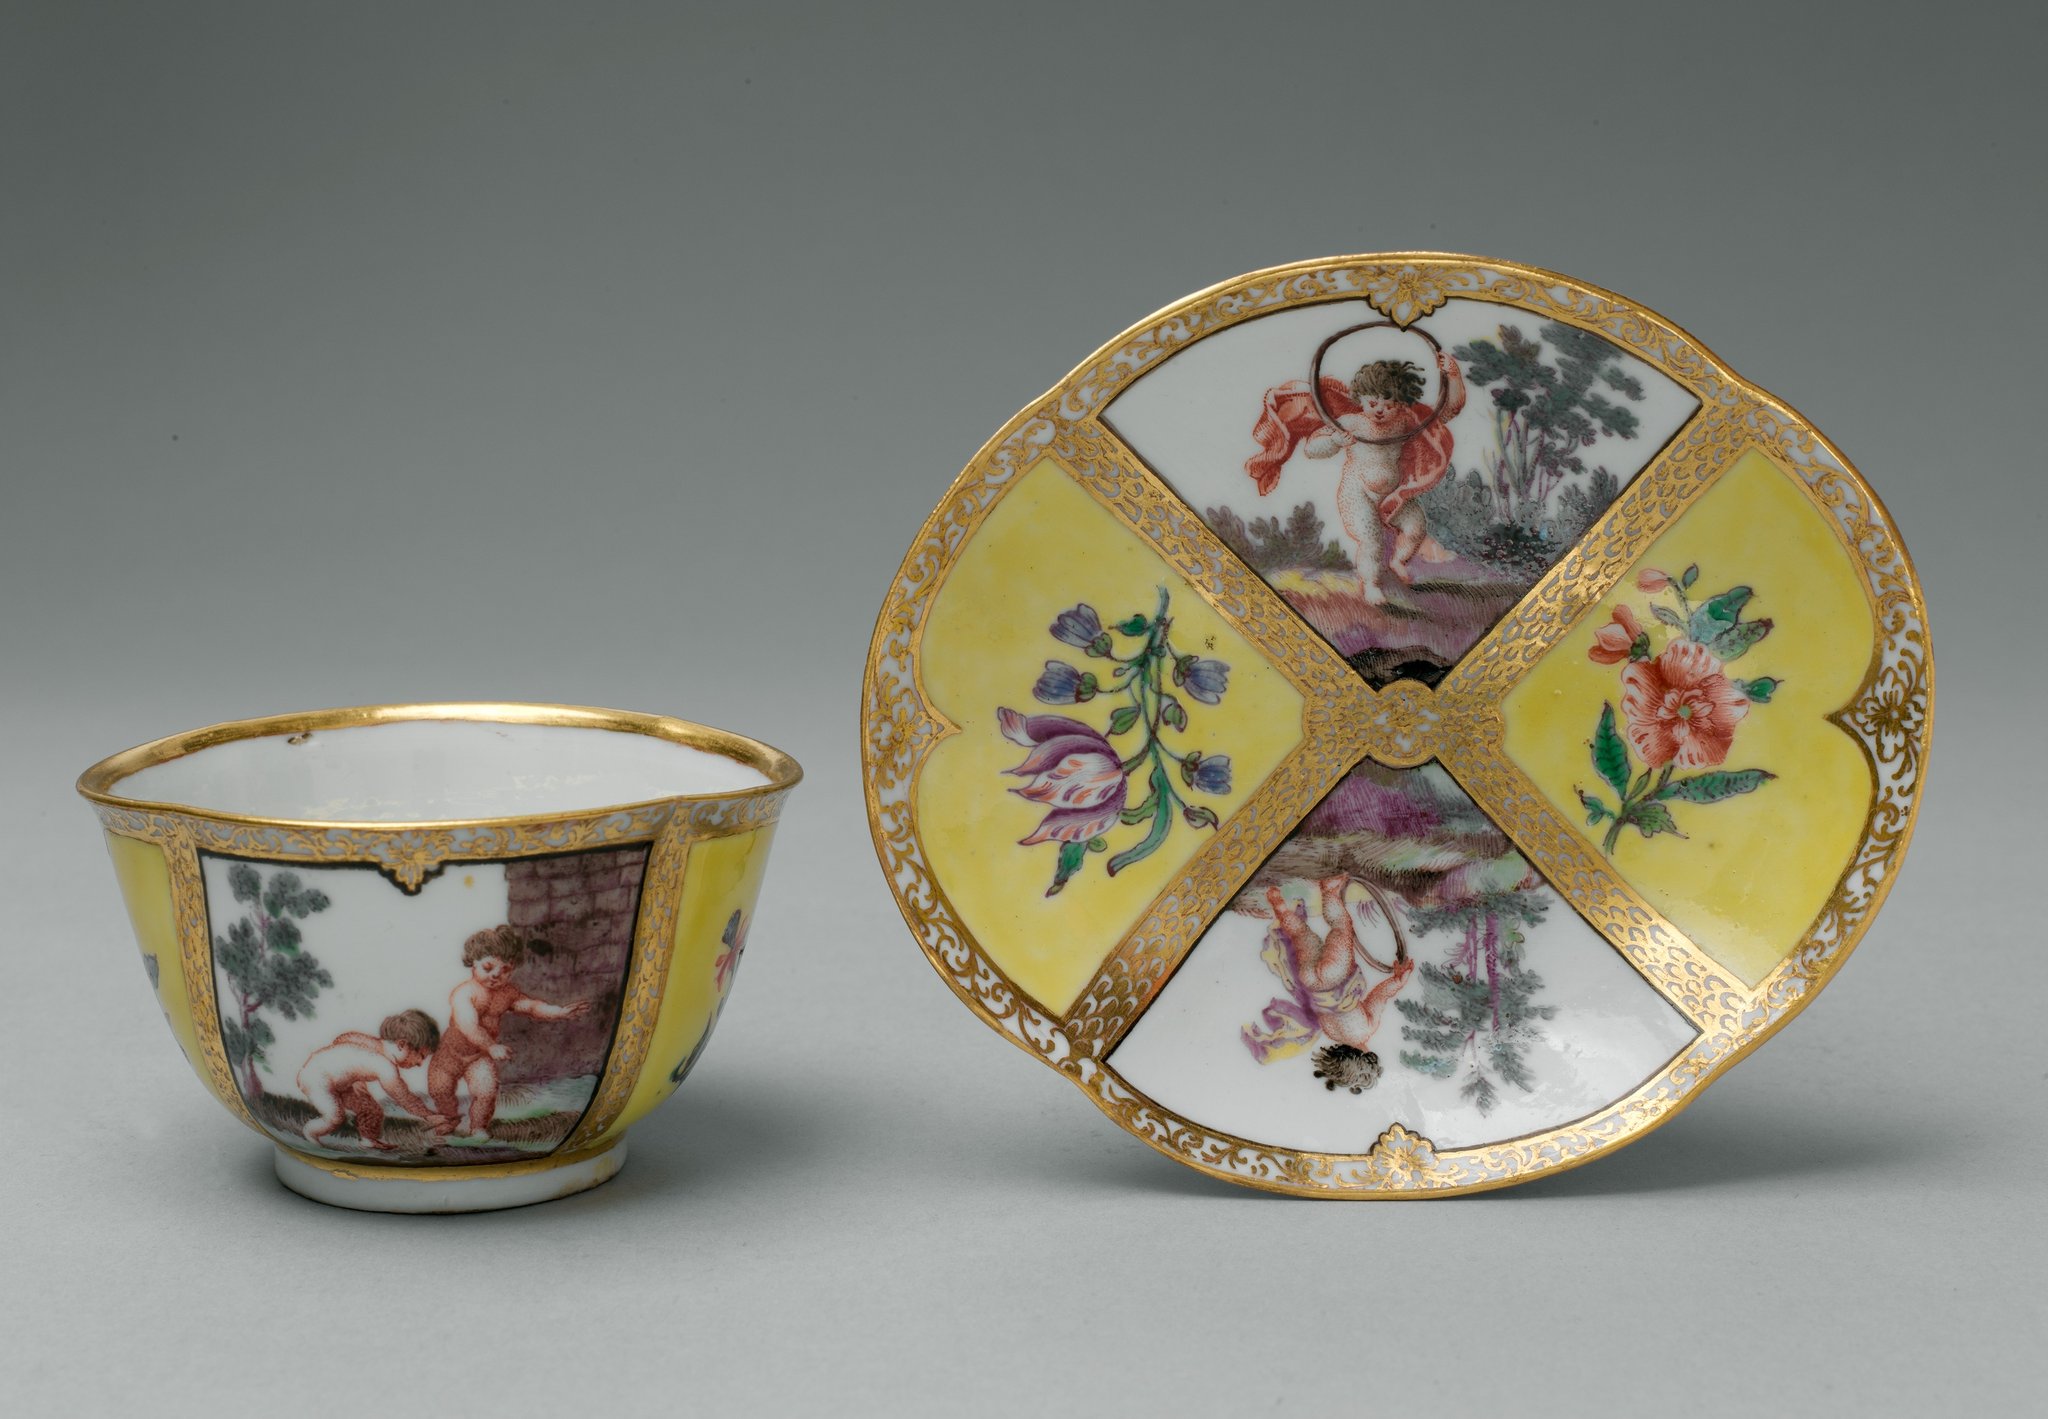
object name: cup and saucer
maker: doccia porcelain manufactory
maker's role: manufactory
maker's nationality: italian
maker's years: 1737-1896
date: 1750-1755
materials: hard paste porcelain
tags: putti,flowers